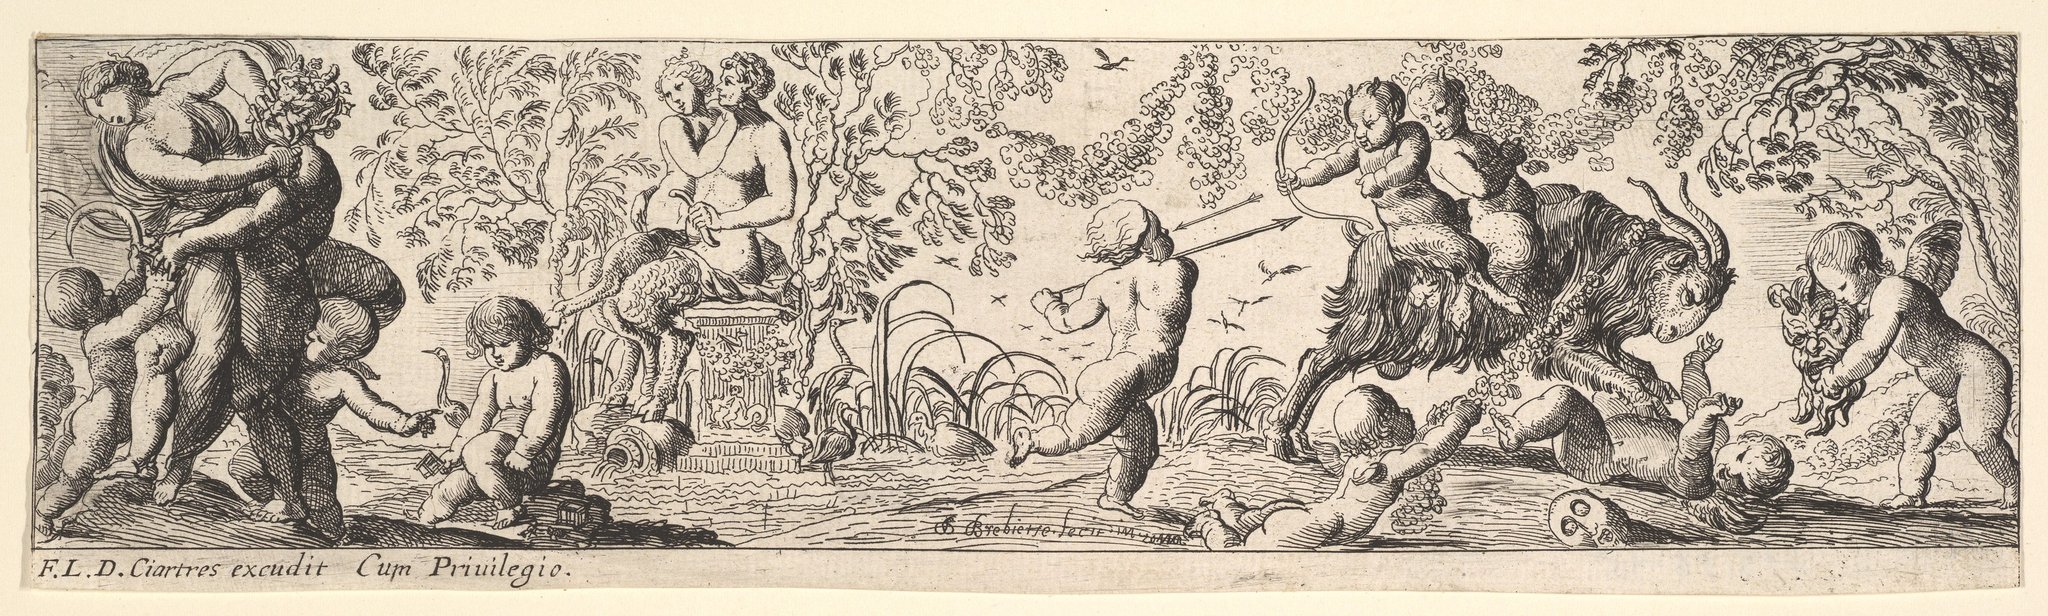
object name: print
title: Bacchanal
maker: pierre brebiette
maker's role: artist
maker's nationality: french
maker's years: 1598-1642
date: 1600-1642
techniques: etching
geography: france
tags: women,putti,satyrs,goats